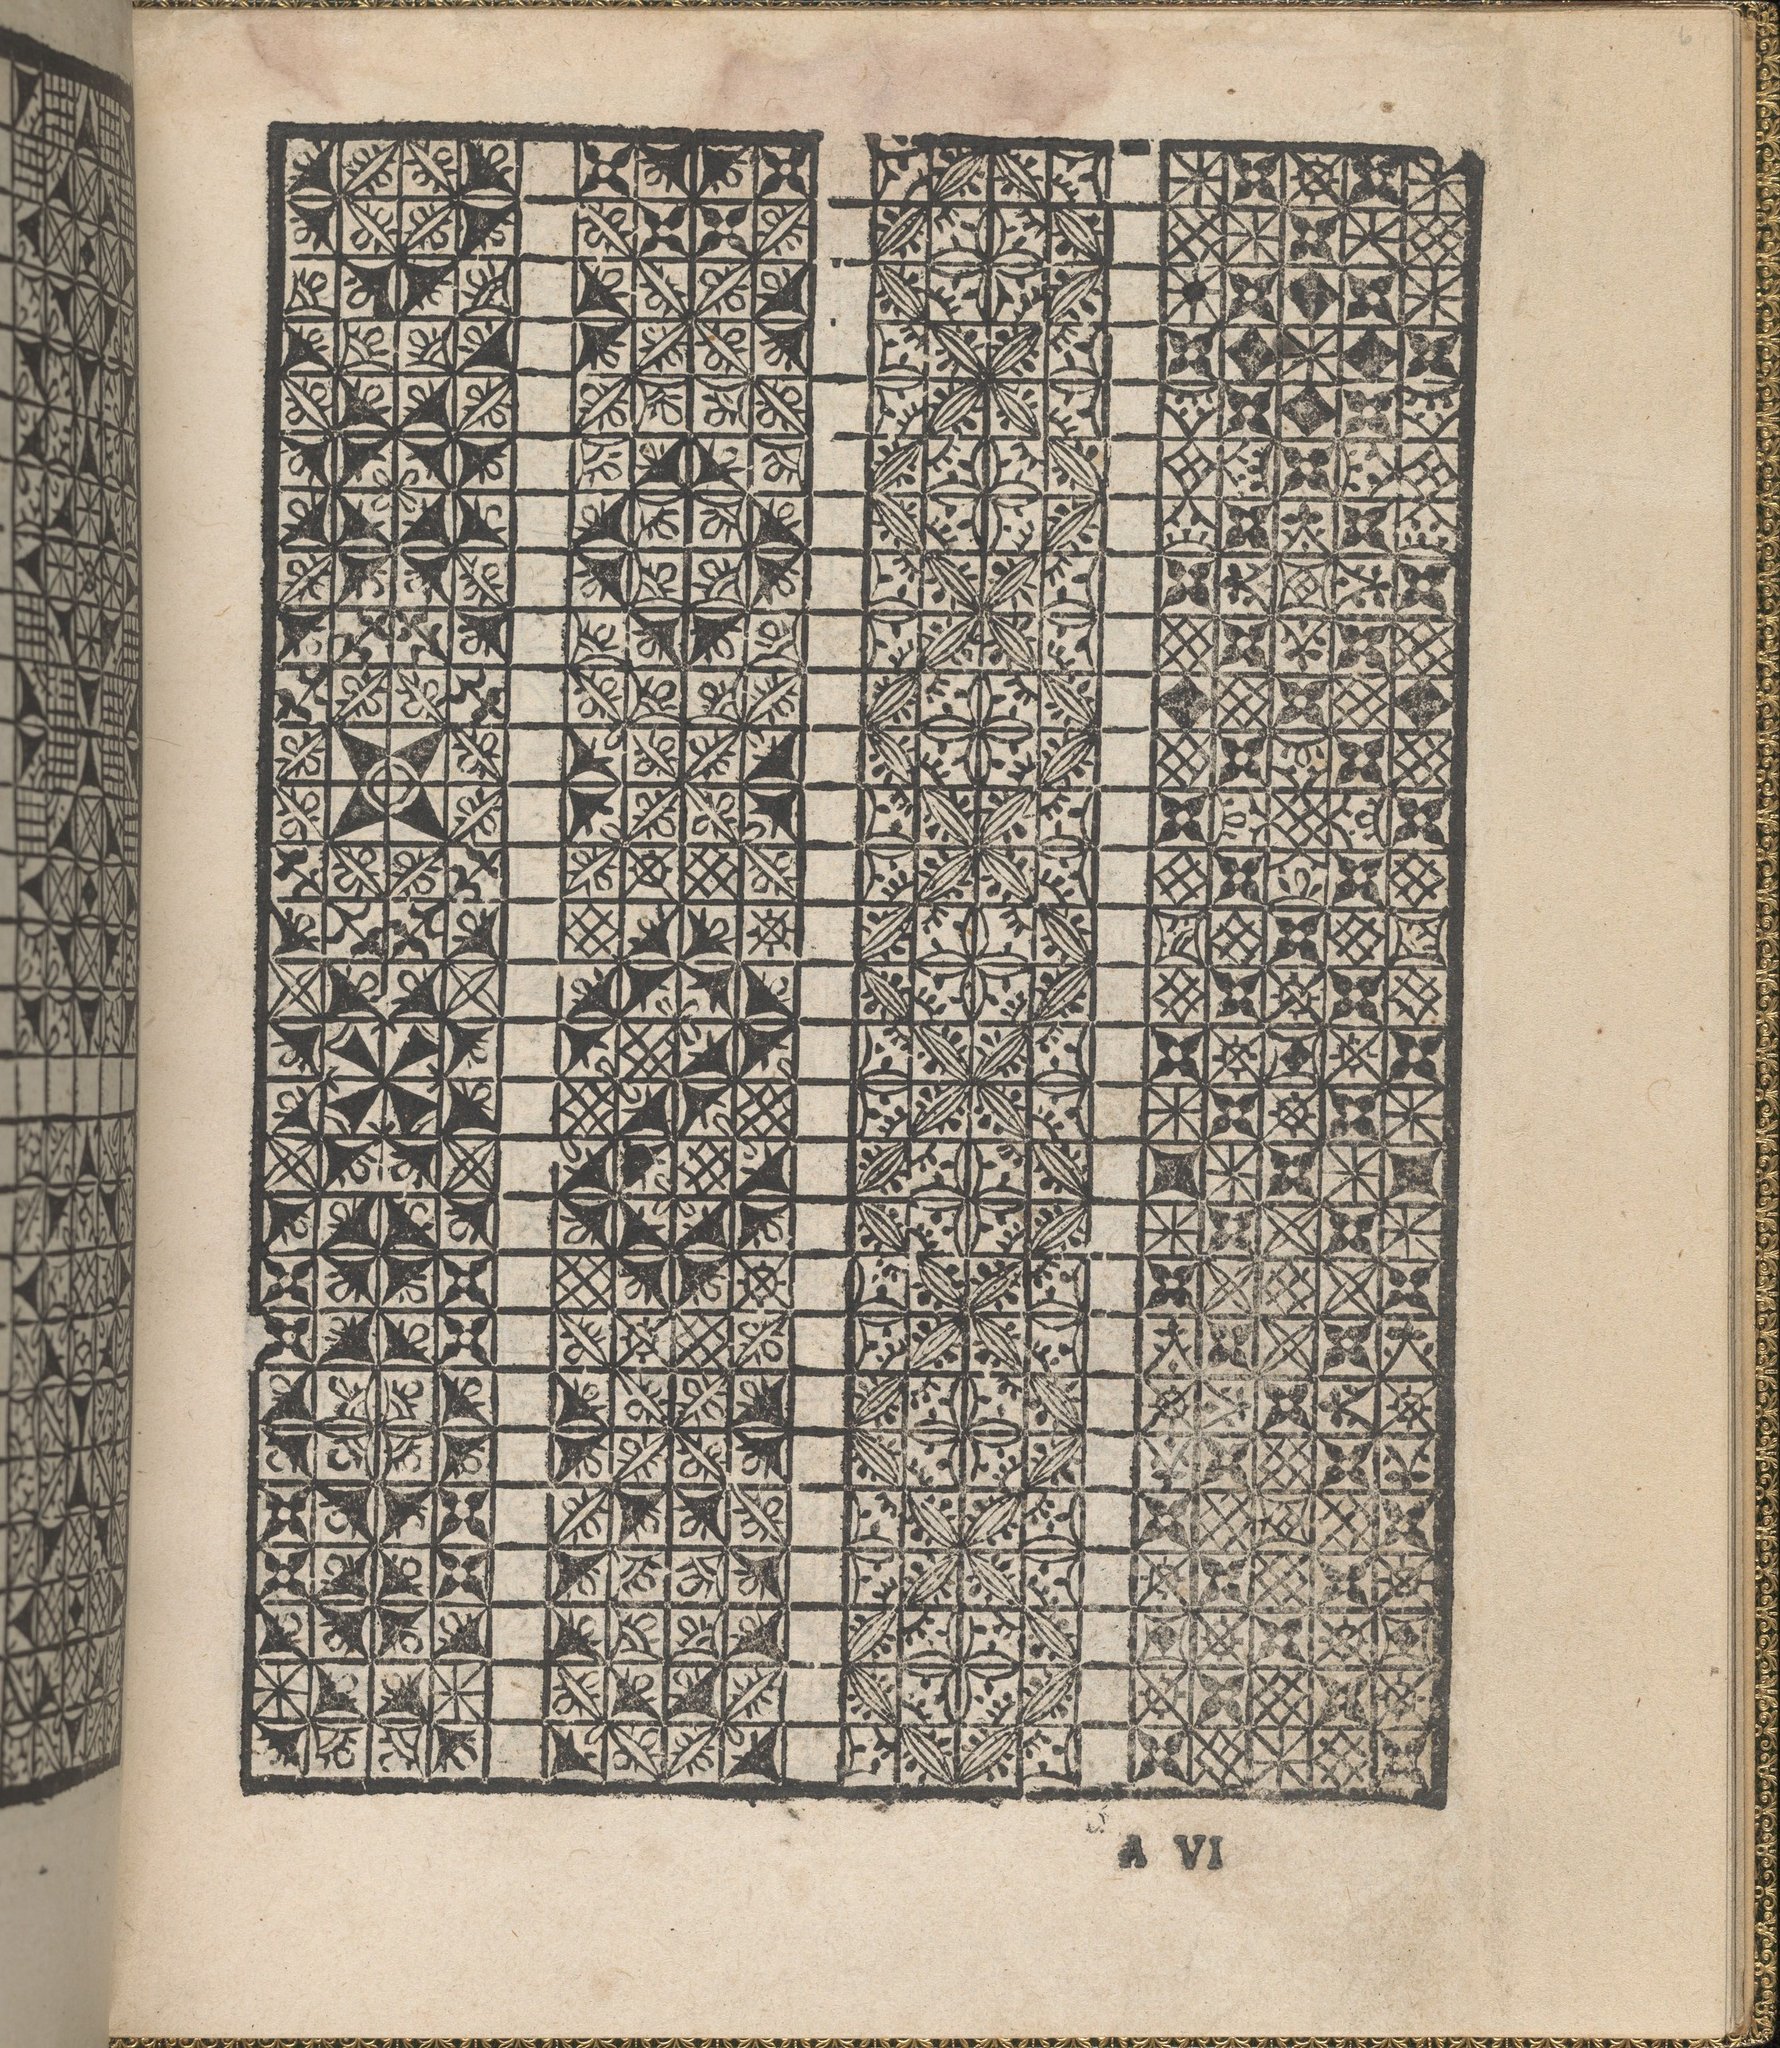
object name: book print ornament architecture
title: Giardineto novo di punti tagliati et gropposi per exercitio & ornamento delle donne (Venice 1554), page 4 (recto)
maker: matteo pagano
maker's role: publisher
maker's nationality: italian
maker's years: 1515-1588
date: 1554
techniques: woodcut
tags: ornament